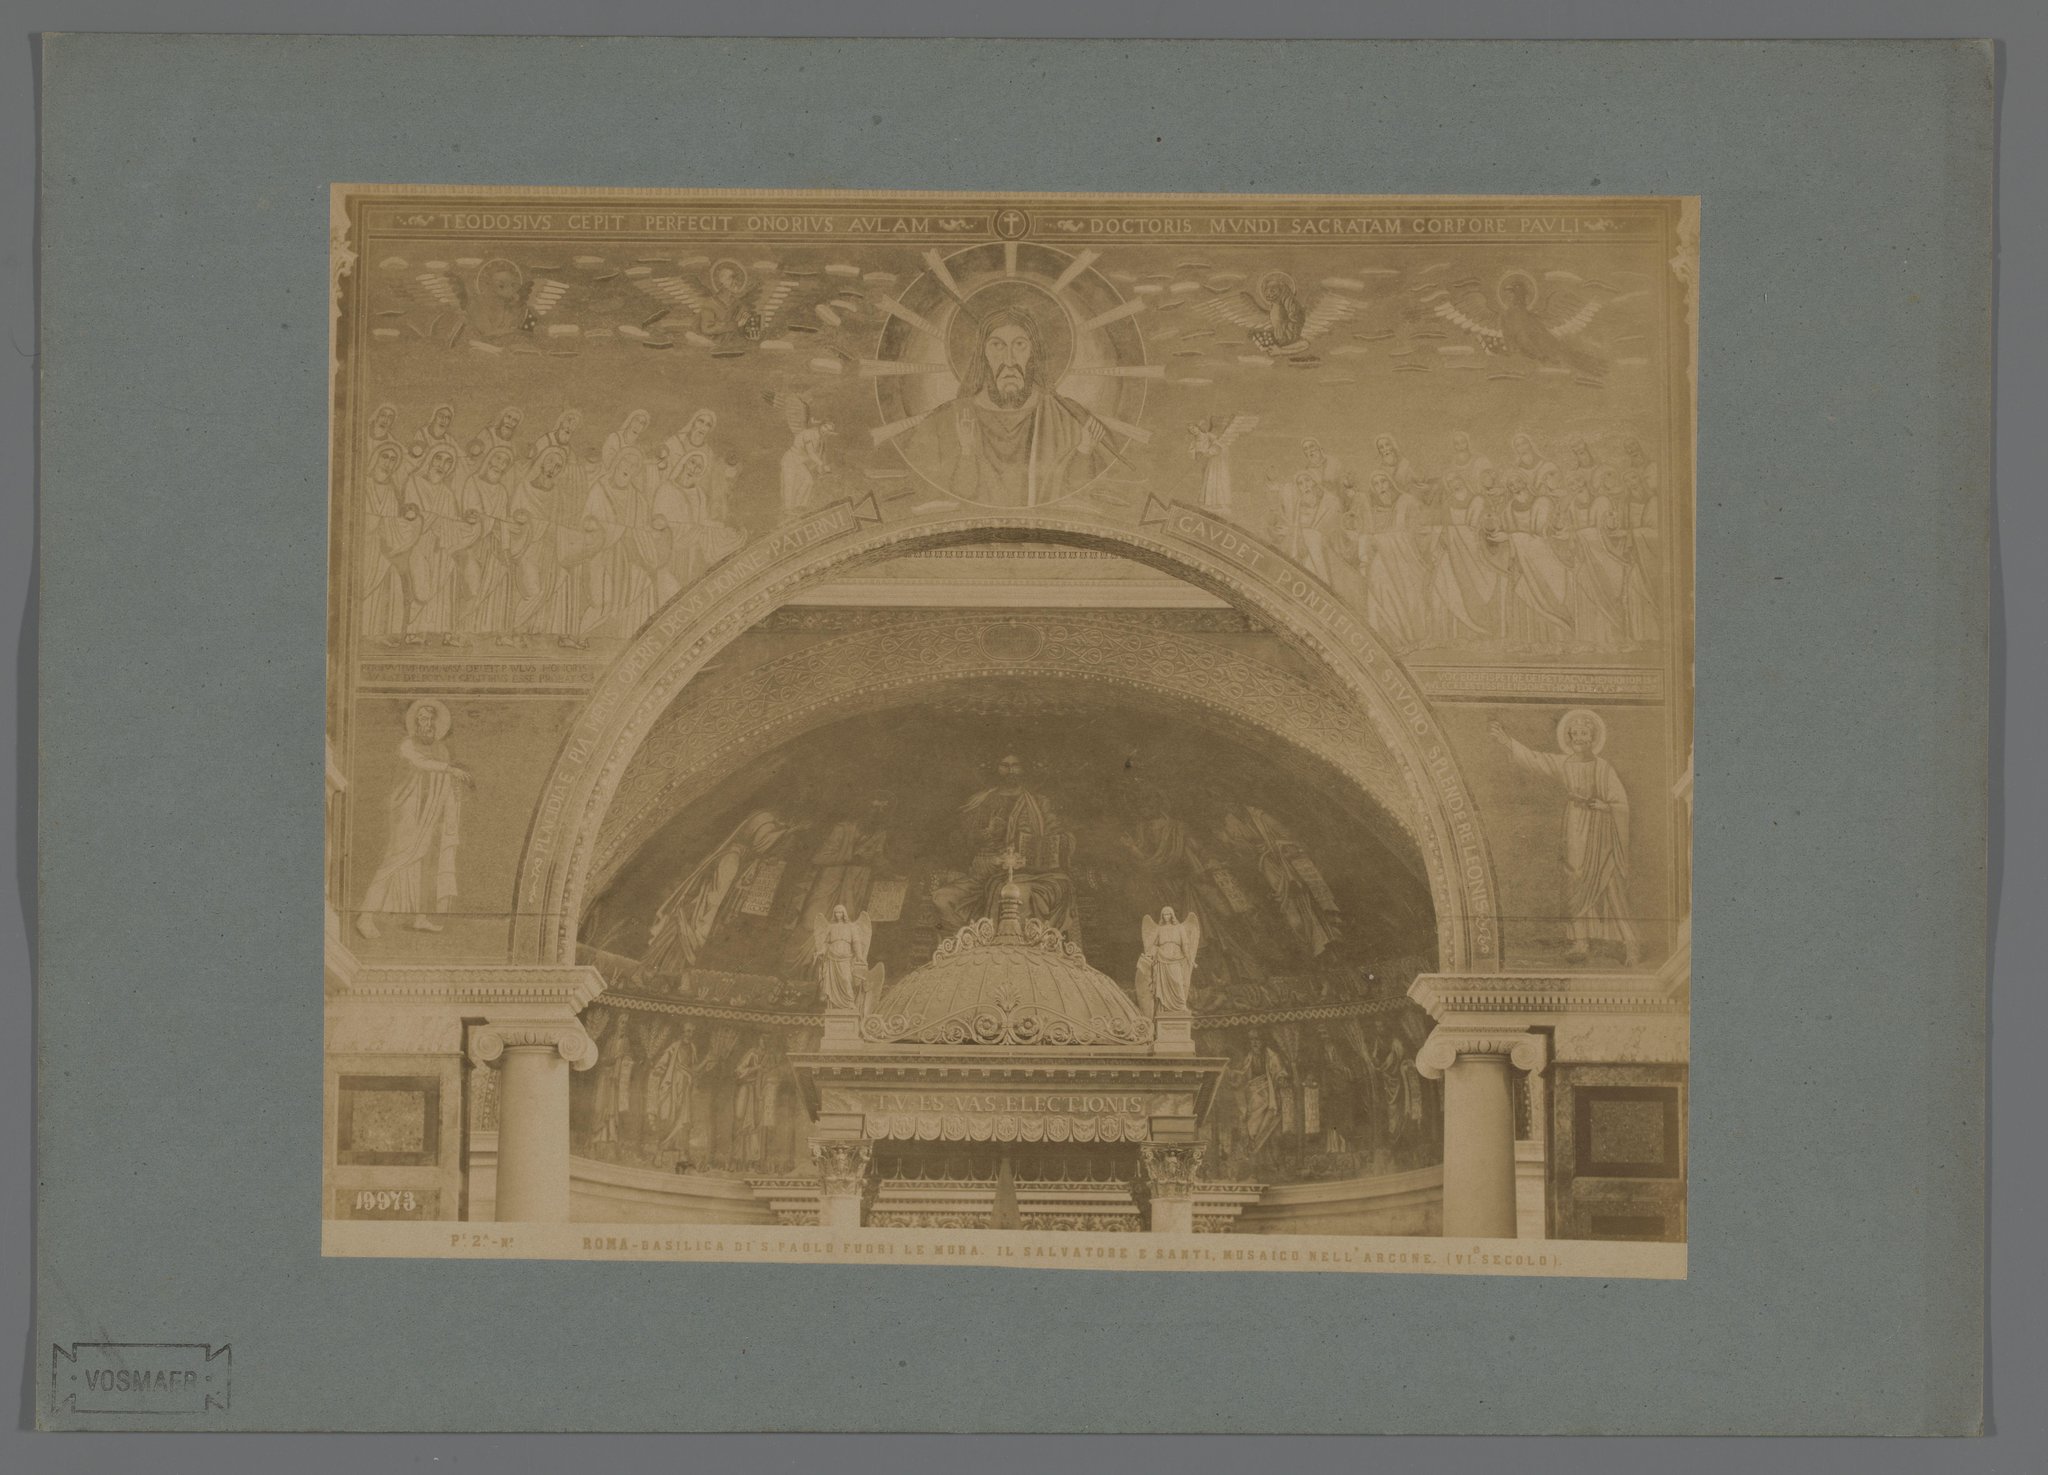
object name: photograph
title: Basilica di S. Paolo fuori le Mura. Il Salvatore e Santi, Musaico nell'Arcone. (VIe secolo)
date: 1852-1900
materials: cardboard, paper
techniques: albumen print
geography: rome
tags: parts of church interior, wall-covering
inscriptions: number: ‘PE. 2A.-No.’, number: ‘19973’, collector's mark: ‘VOSMAER’